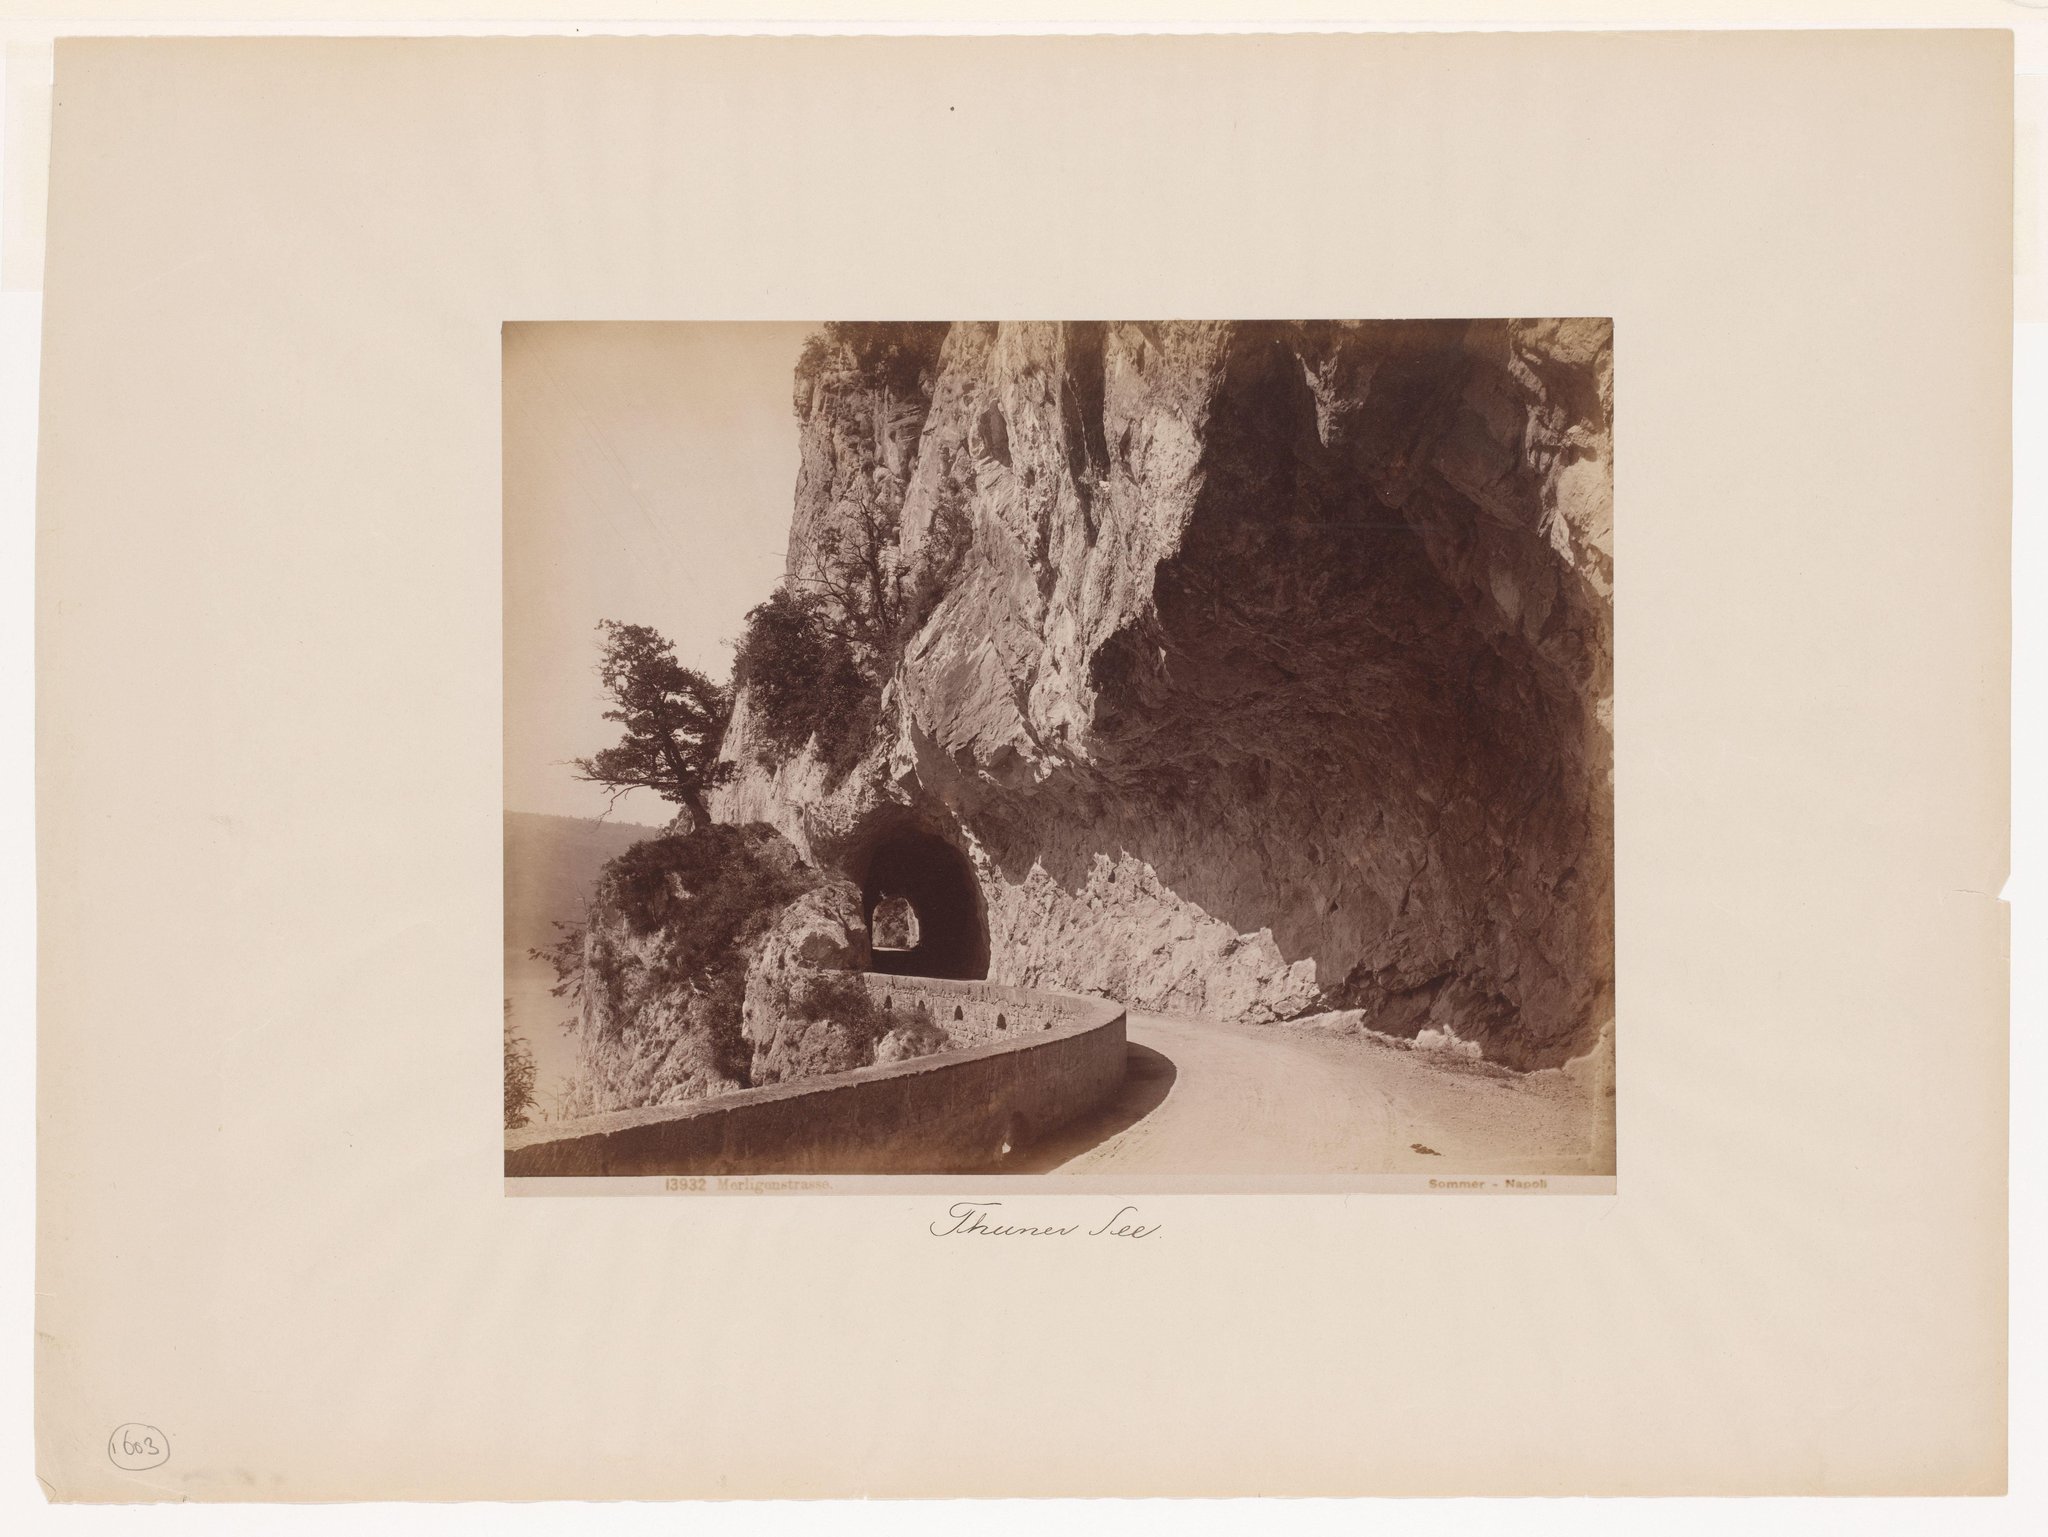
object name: photograph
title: Merligenstrasse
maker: giorgio sommer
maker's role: fotograaf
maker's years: 1834-1914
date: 1857-1914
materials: cardboard, paper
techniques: albumen print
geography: thunersee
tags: public road, mountains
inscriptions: inscription: ‘Thuner See’, number: ‘1603’, number: ‘13932’